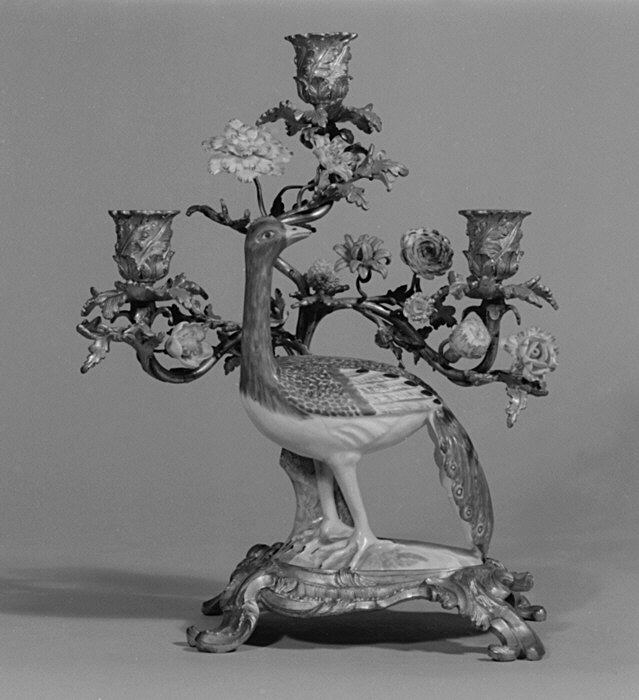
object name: candelabrum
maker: meissen manufactory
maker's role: manufactory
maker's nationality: german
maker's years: 1710-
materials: gilt bronze, hard paste porcelain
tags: peacocks,flowers